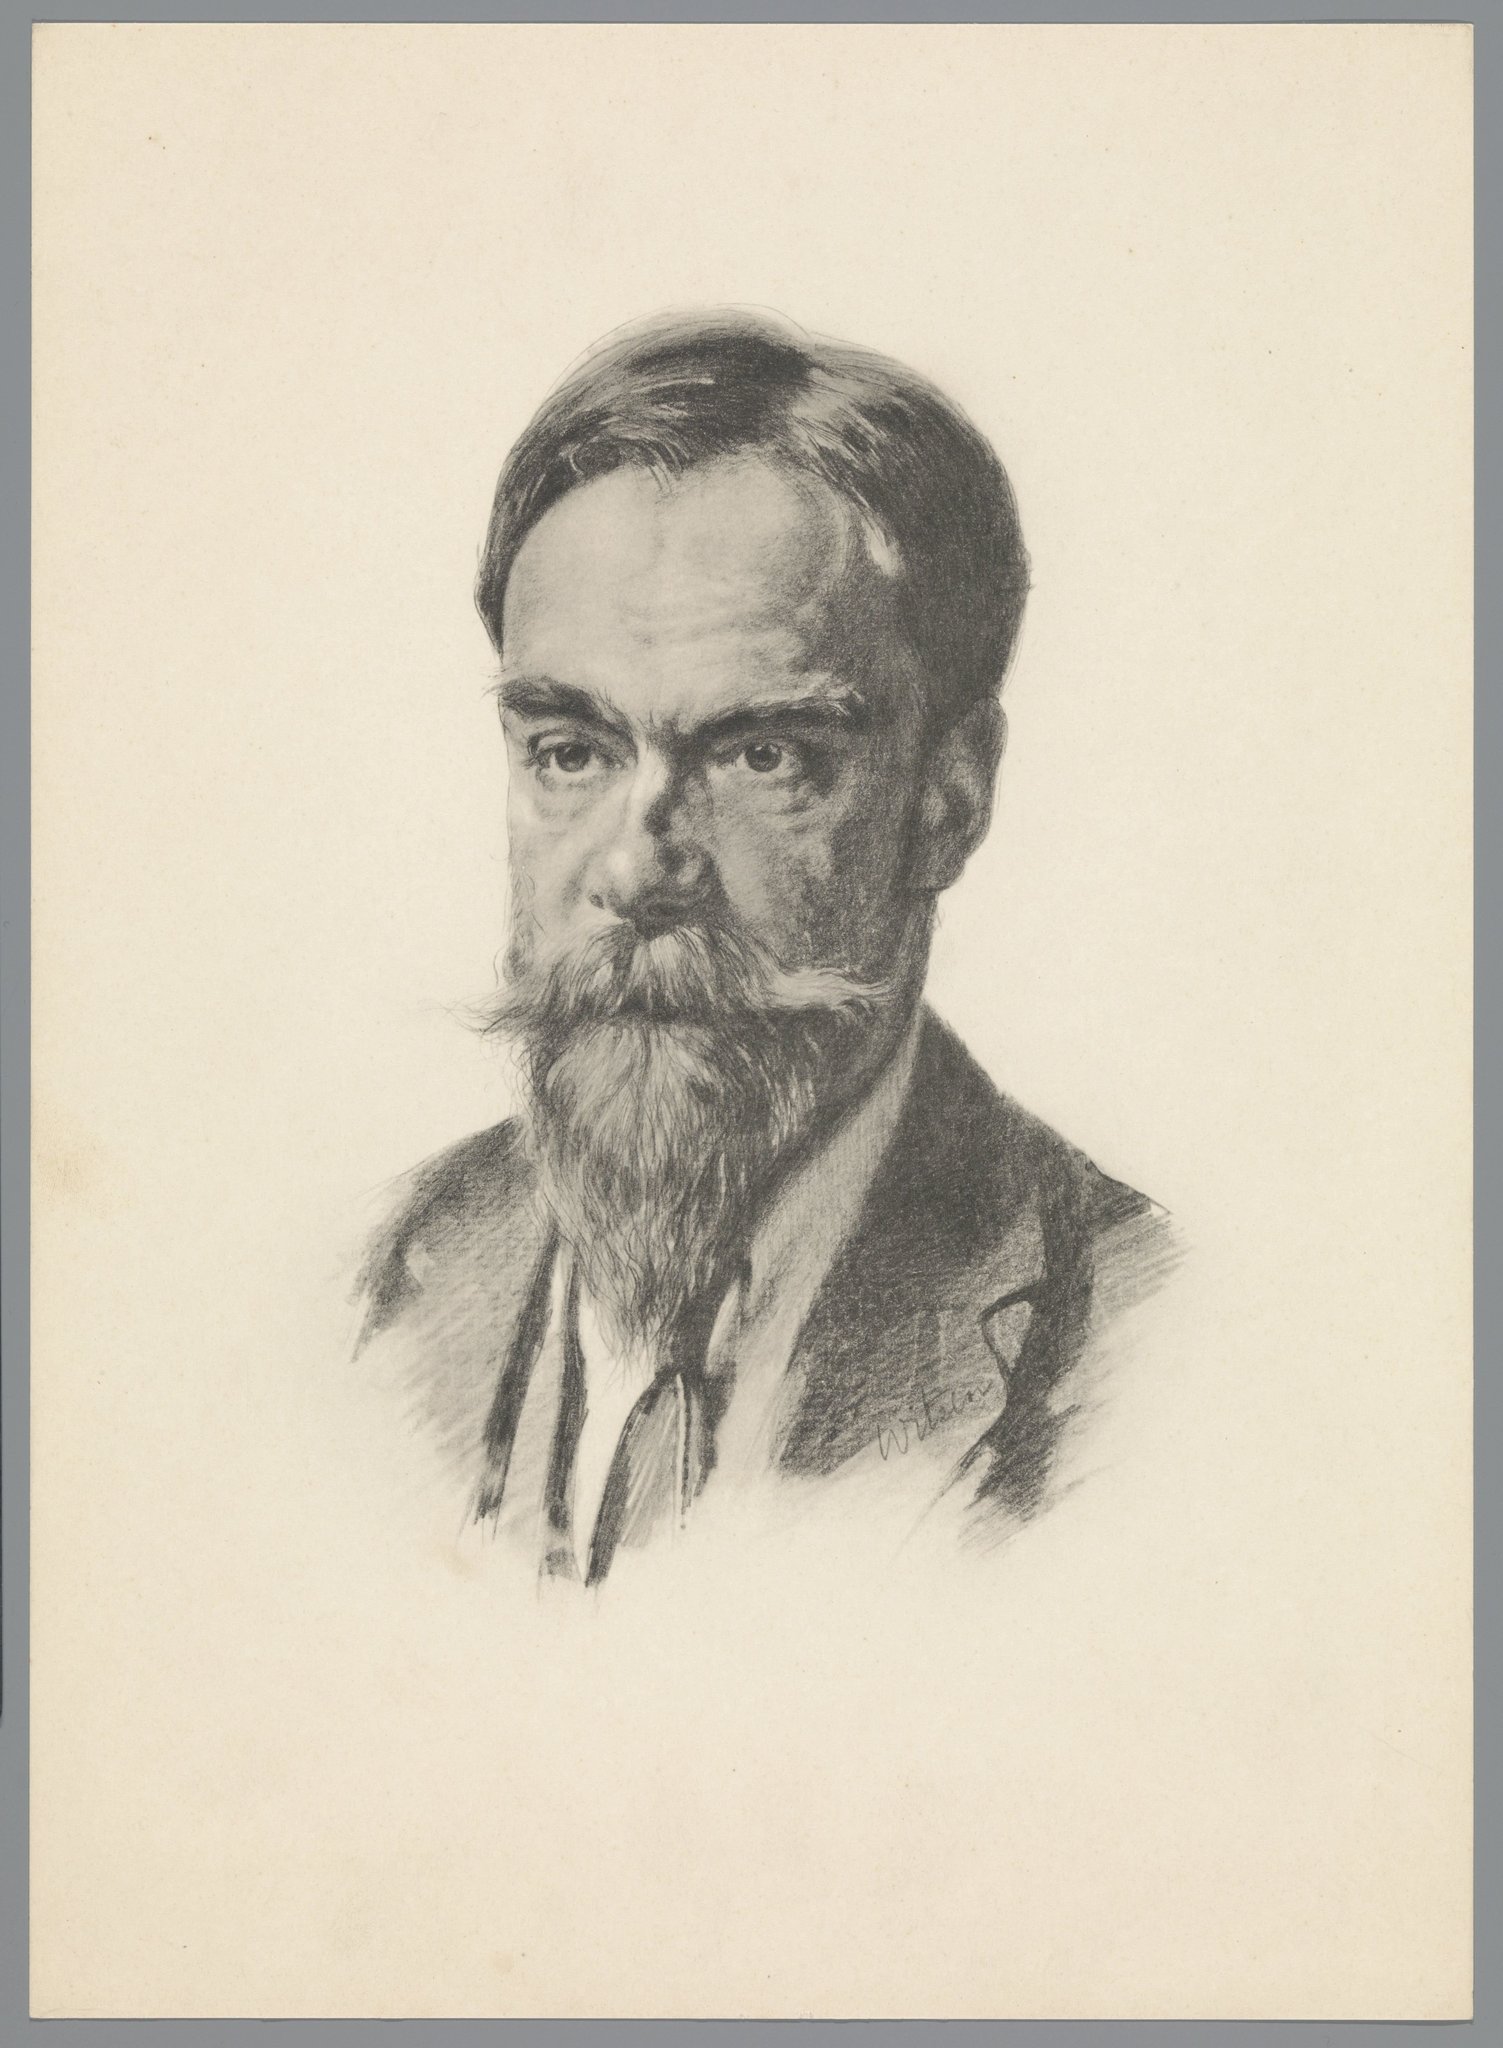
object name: print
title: Reproductie naar krijttekening met portret van Frans Coenen Jr.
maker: Anonymous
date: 1860-1915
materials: paper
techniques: photograph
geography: netherlands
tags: amsterdam, frans coenen (1866-1936)